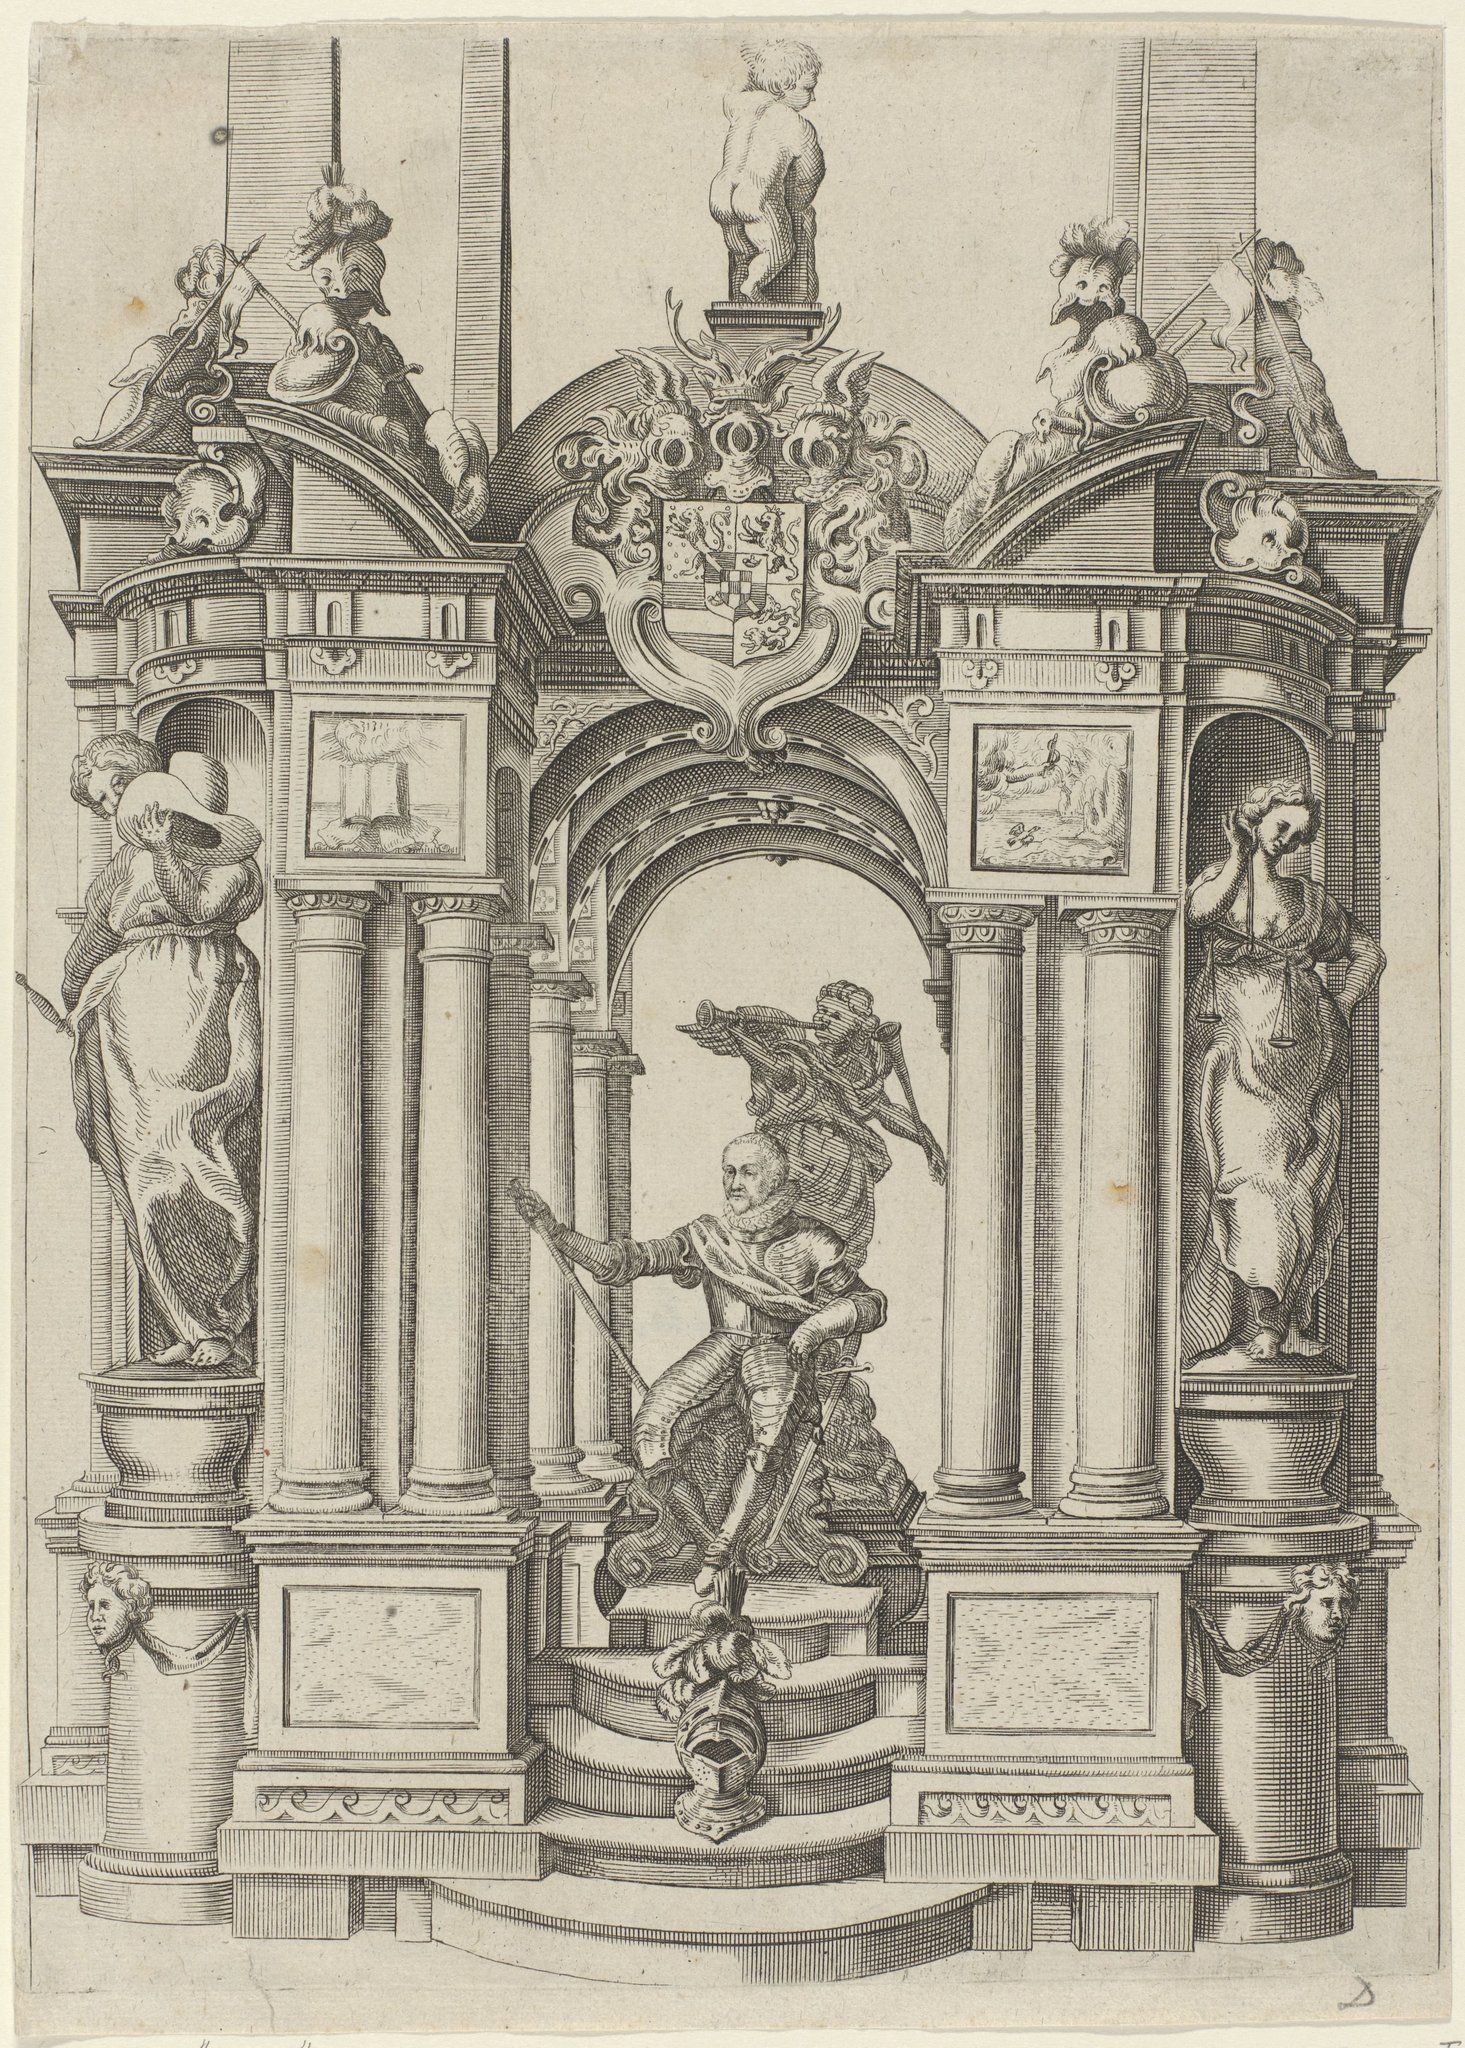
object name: book illustration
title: Architectura moderna ofte Bouwinge van onsen tyt (...) mr. Hendrick de Keyser (...) en Cornelis Danckerts (...) Amsterdam 1631, pl. XXXIX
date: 1631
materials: paper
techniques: engraving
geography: low countries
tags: william i (prince of orange), historical persons, interior of church, grave-building, monumental tomb, delft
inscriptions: collector's mark: Lugt 2227, collector's mark: Lugt 963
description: De hier vermelde titel verwijst naar de hoogst verkregen titel van de geportretteerde, niet per se naar de titel die de geportretteerde op deze voorstelling draagt. Prent uit: Architectura moderna ofte bouwinge van onsen tyt (...) alle gedaen by (...) Hendrick de Keyser. Amsterdam: Cornelis Danckerts, 1631.